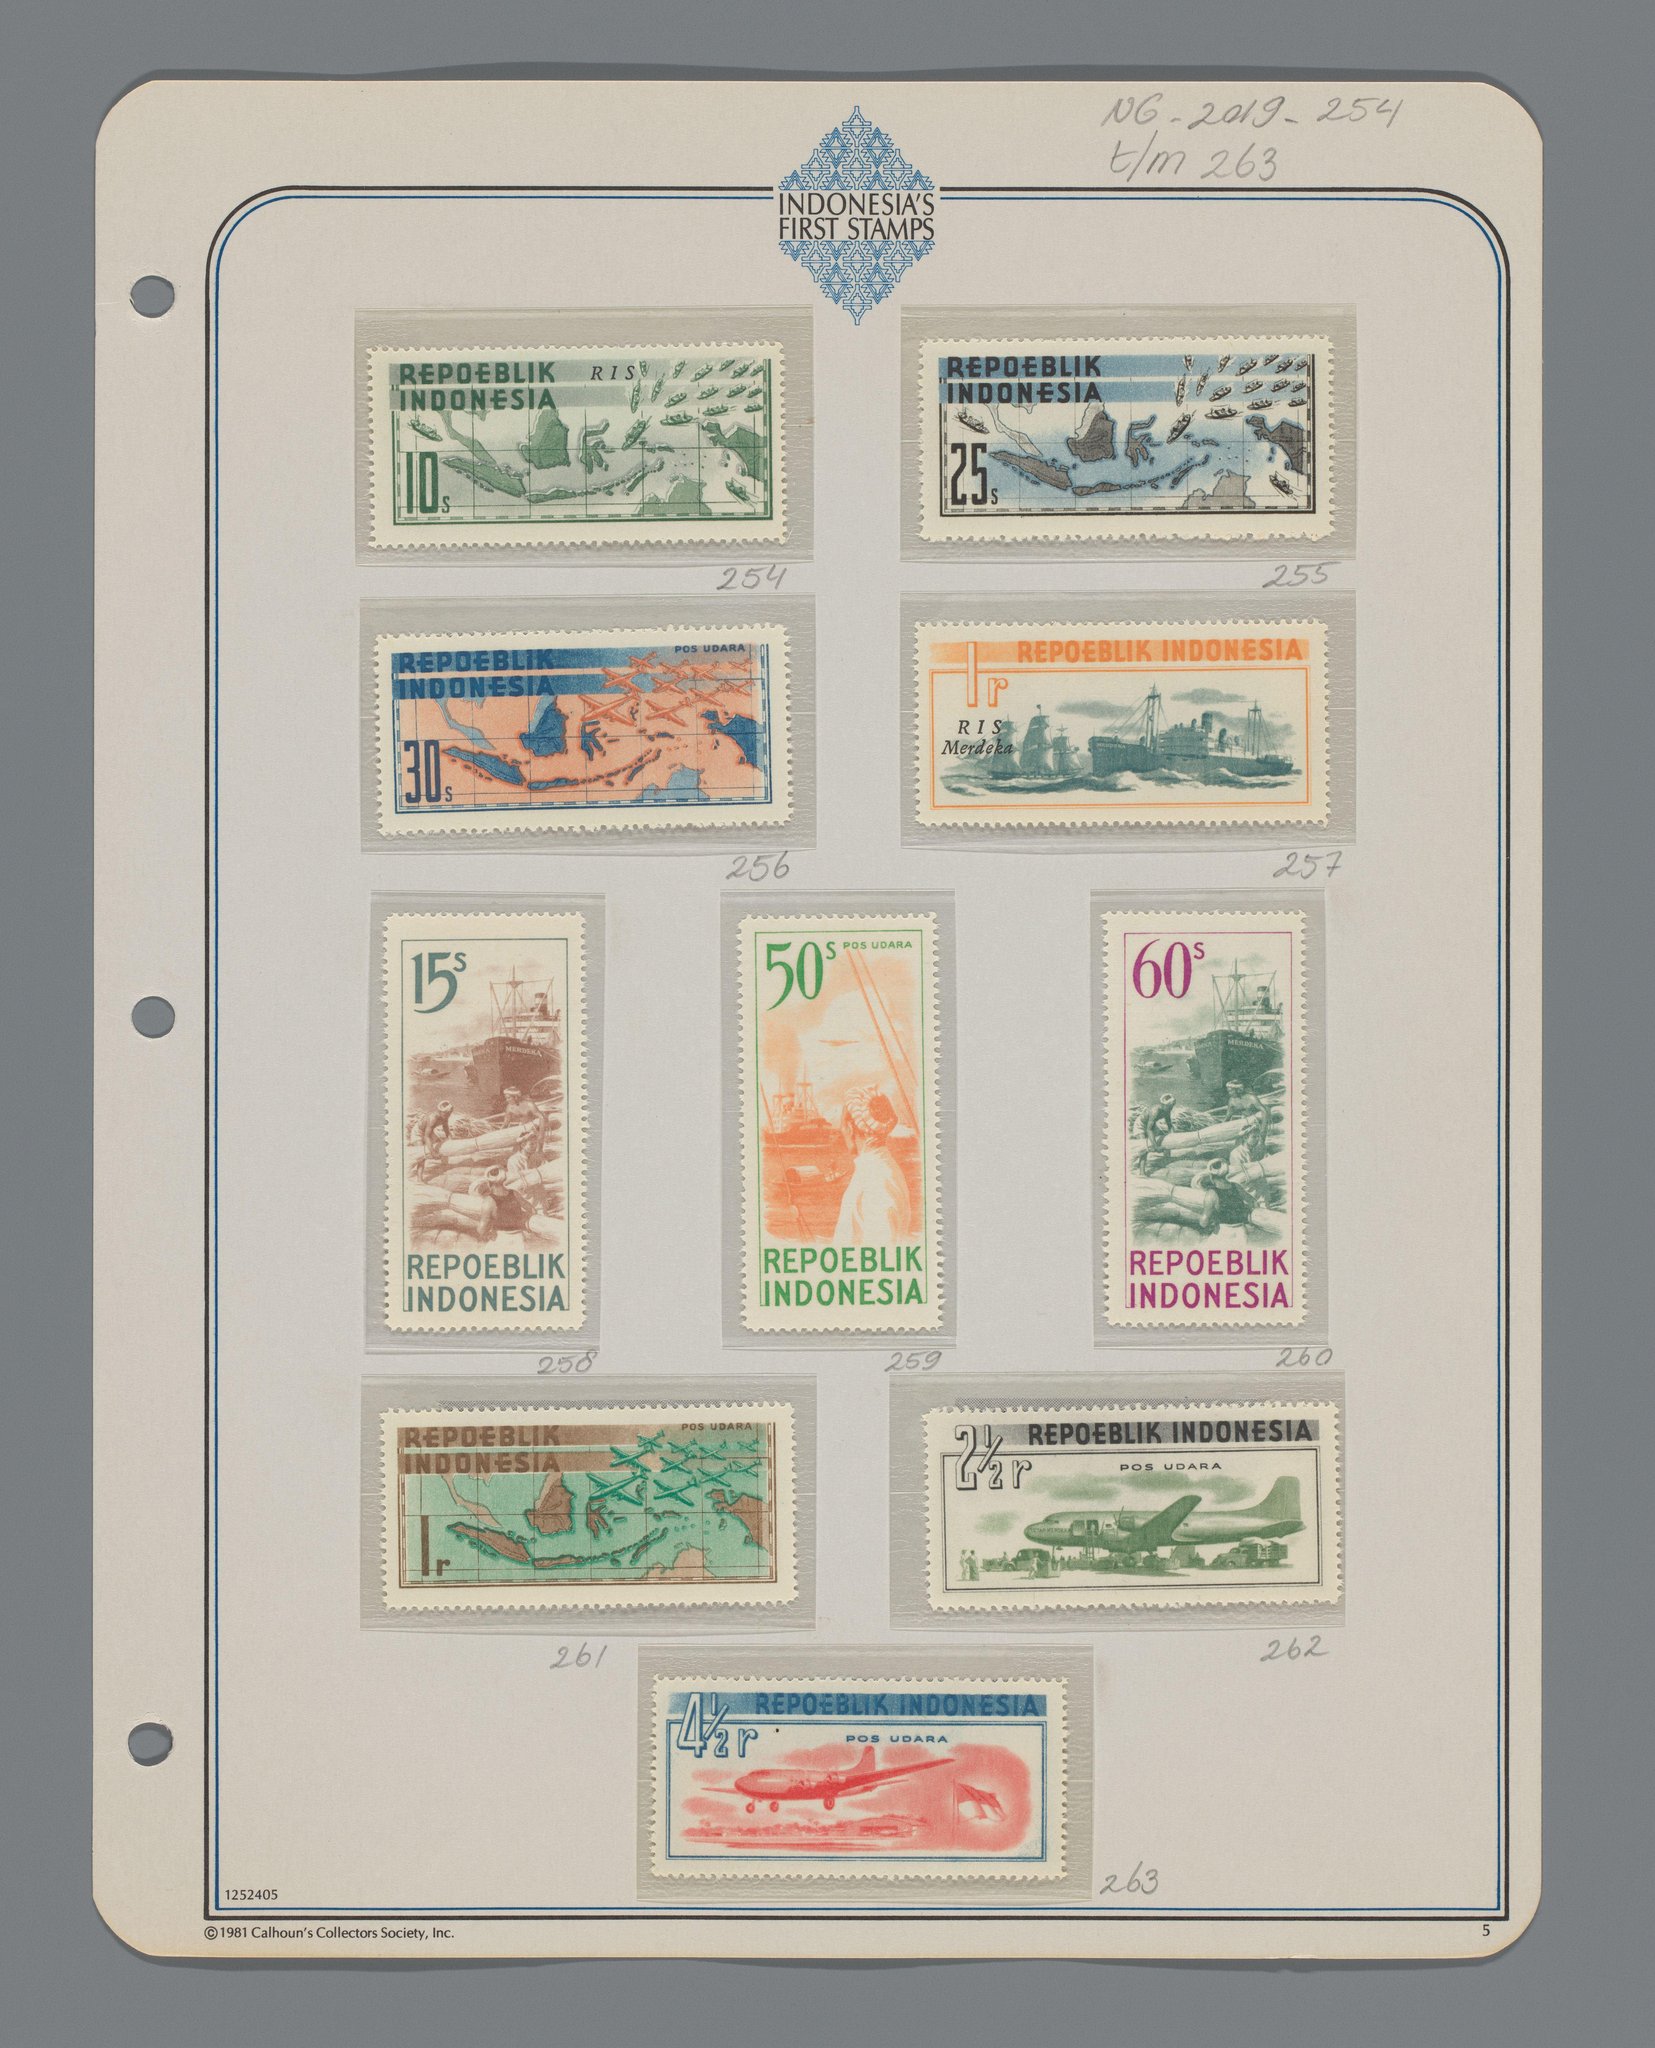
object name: postage stamp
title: Postzegel Republik Indonesia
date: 1949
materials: paper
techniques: photoaquatint, engraving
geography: vienna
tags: indonesia